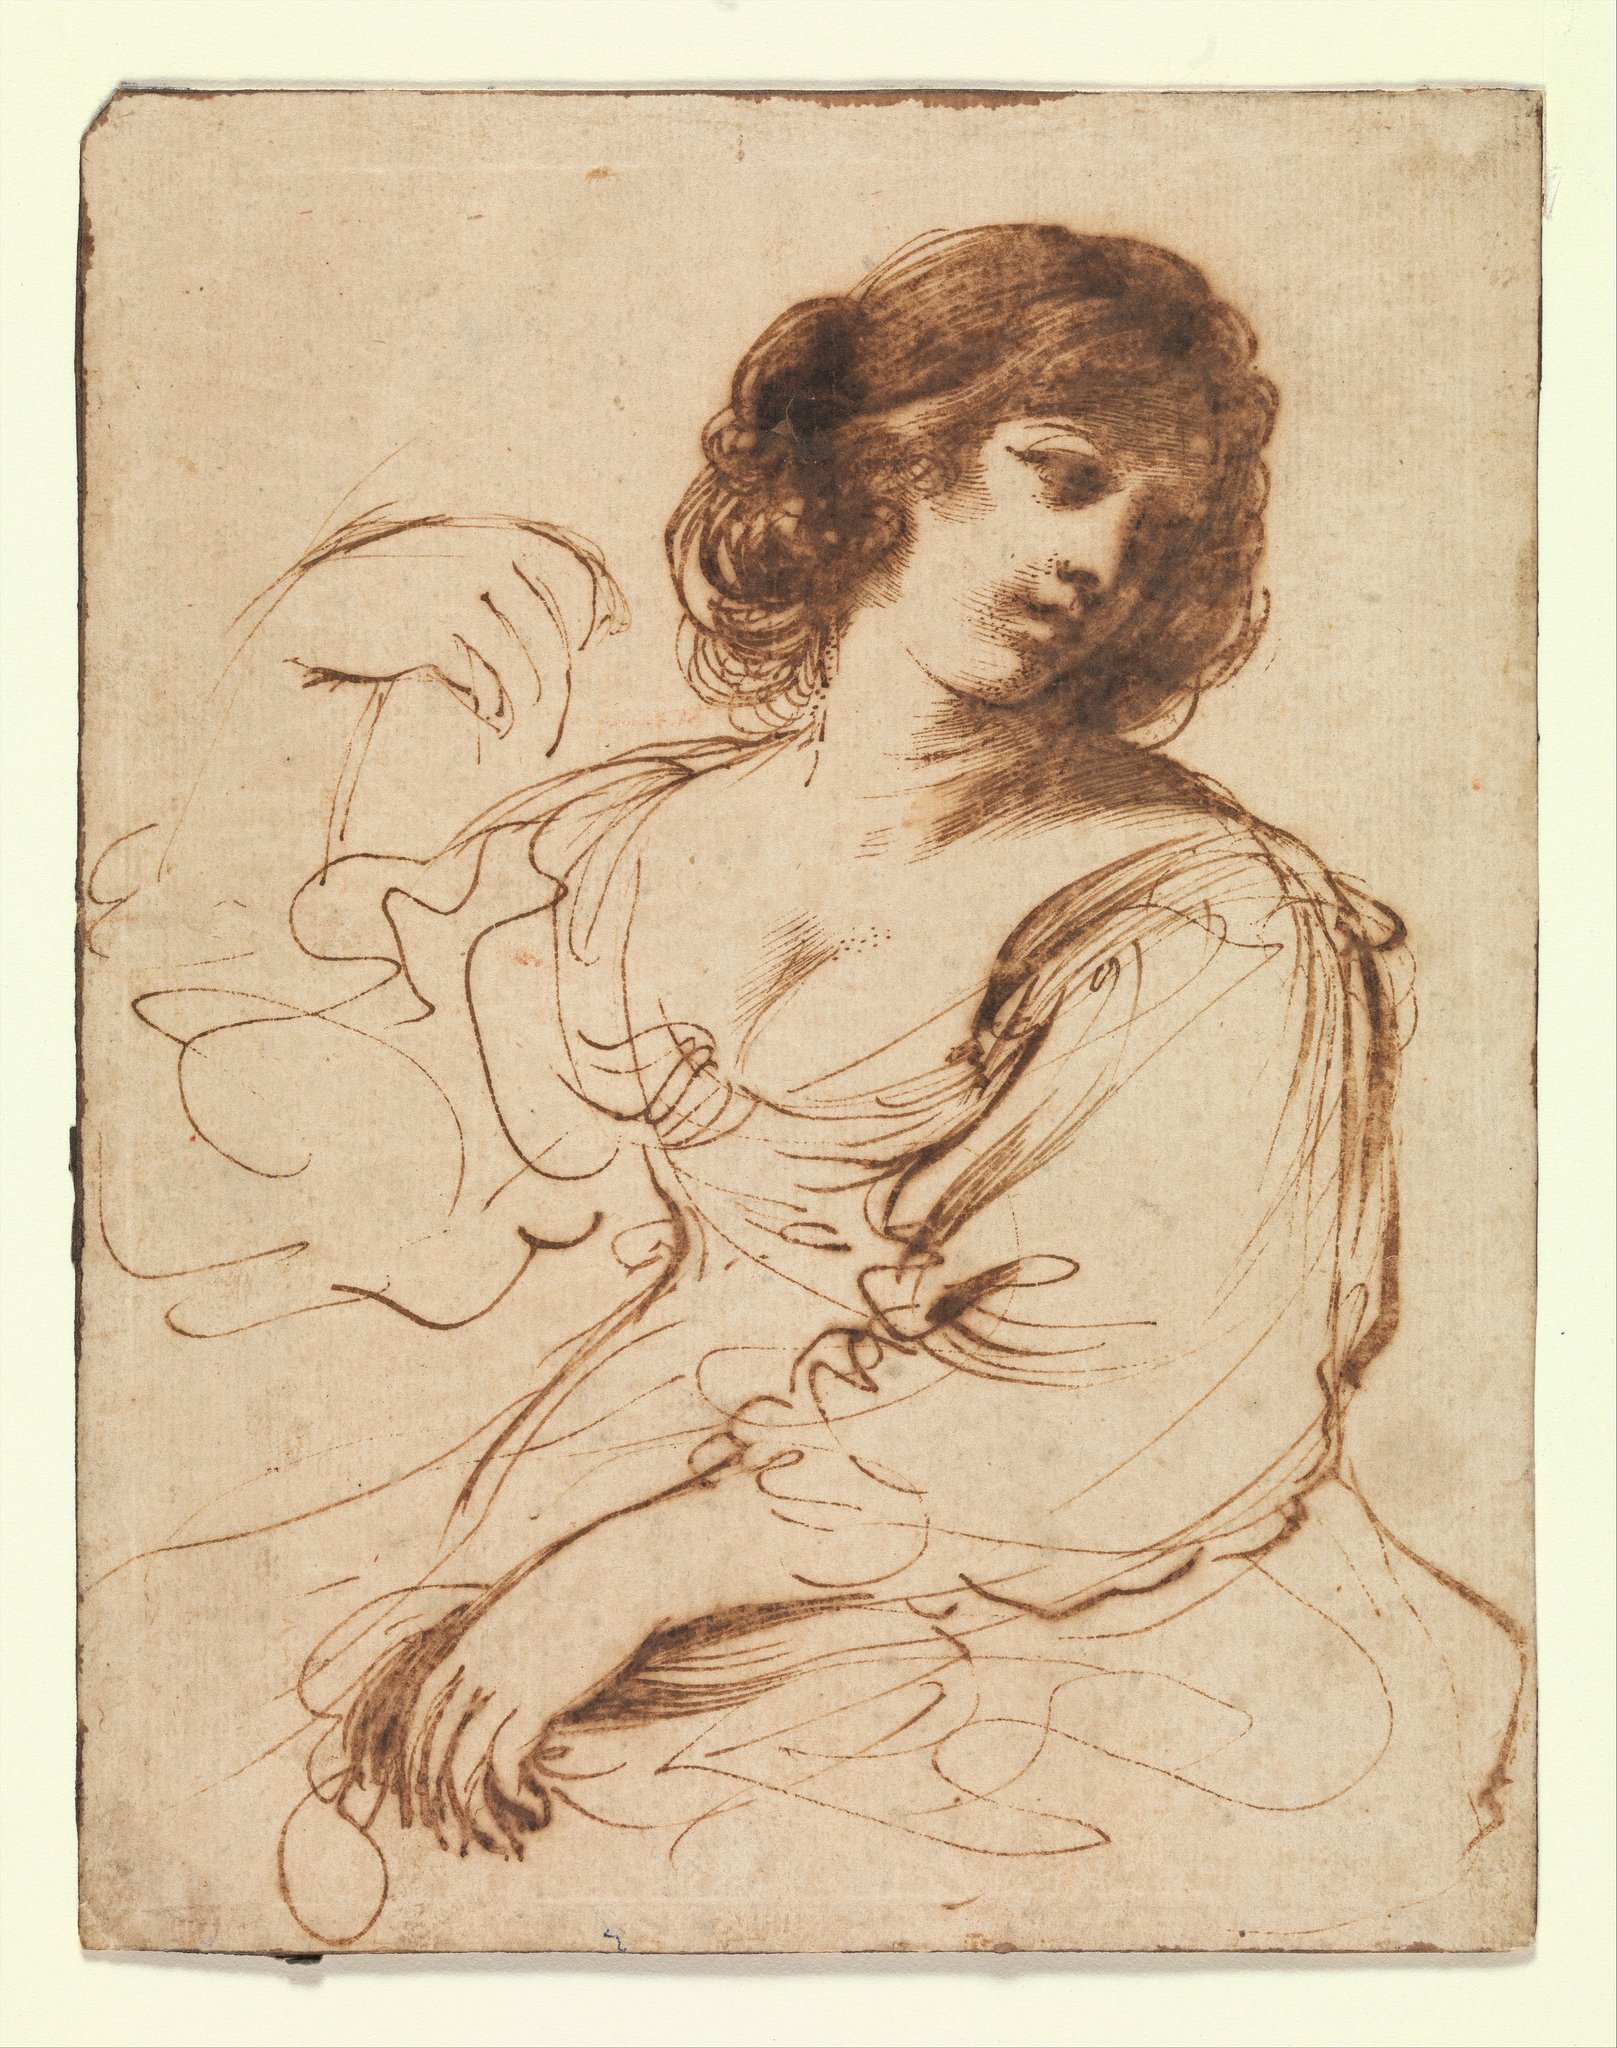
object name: drawing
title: A Seated Young Woman Looking Over Her Shoulder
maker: guercino (giovanni francesco barbieri)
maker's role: artist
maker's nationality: italian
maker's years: 1591-1666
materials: ink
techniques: pen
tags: women